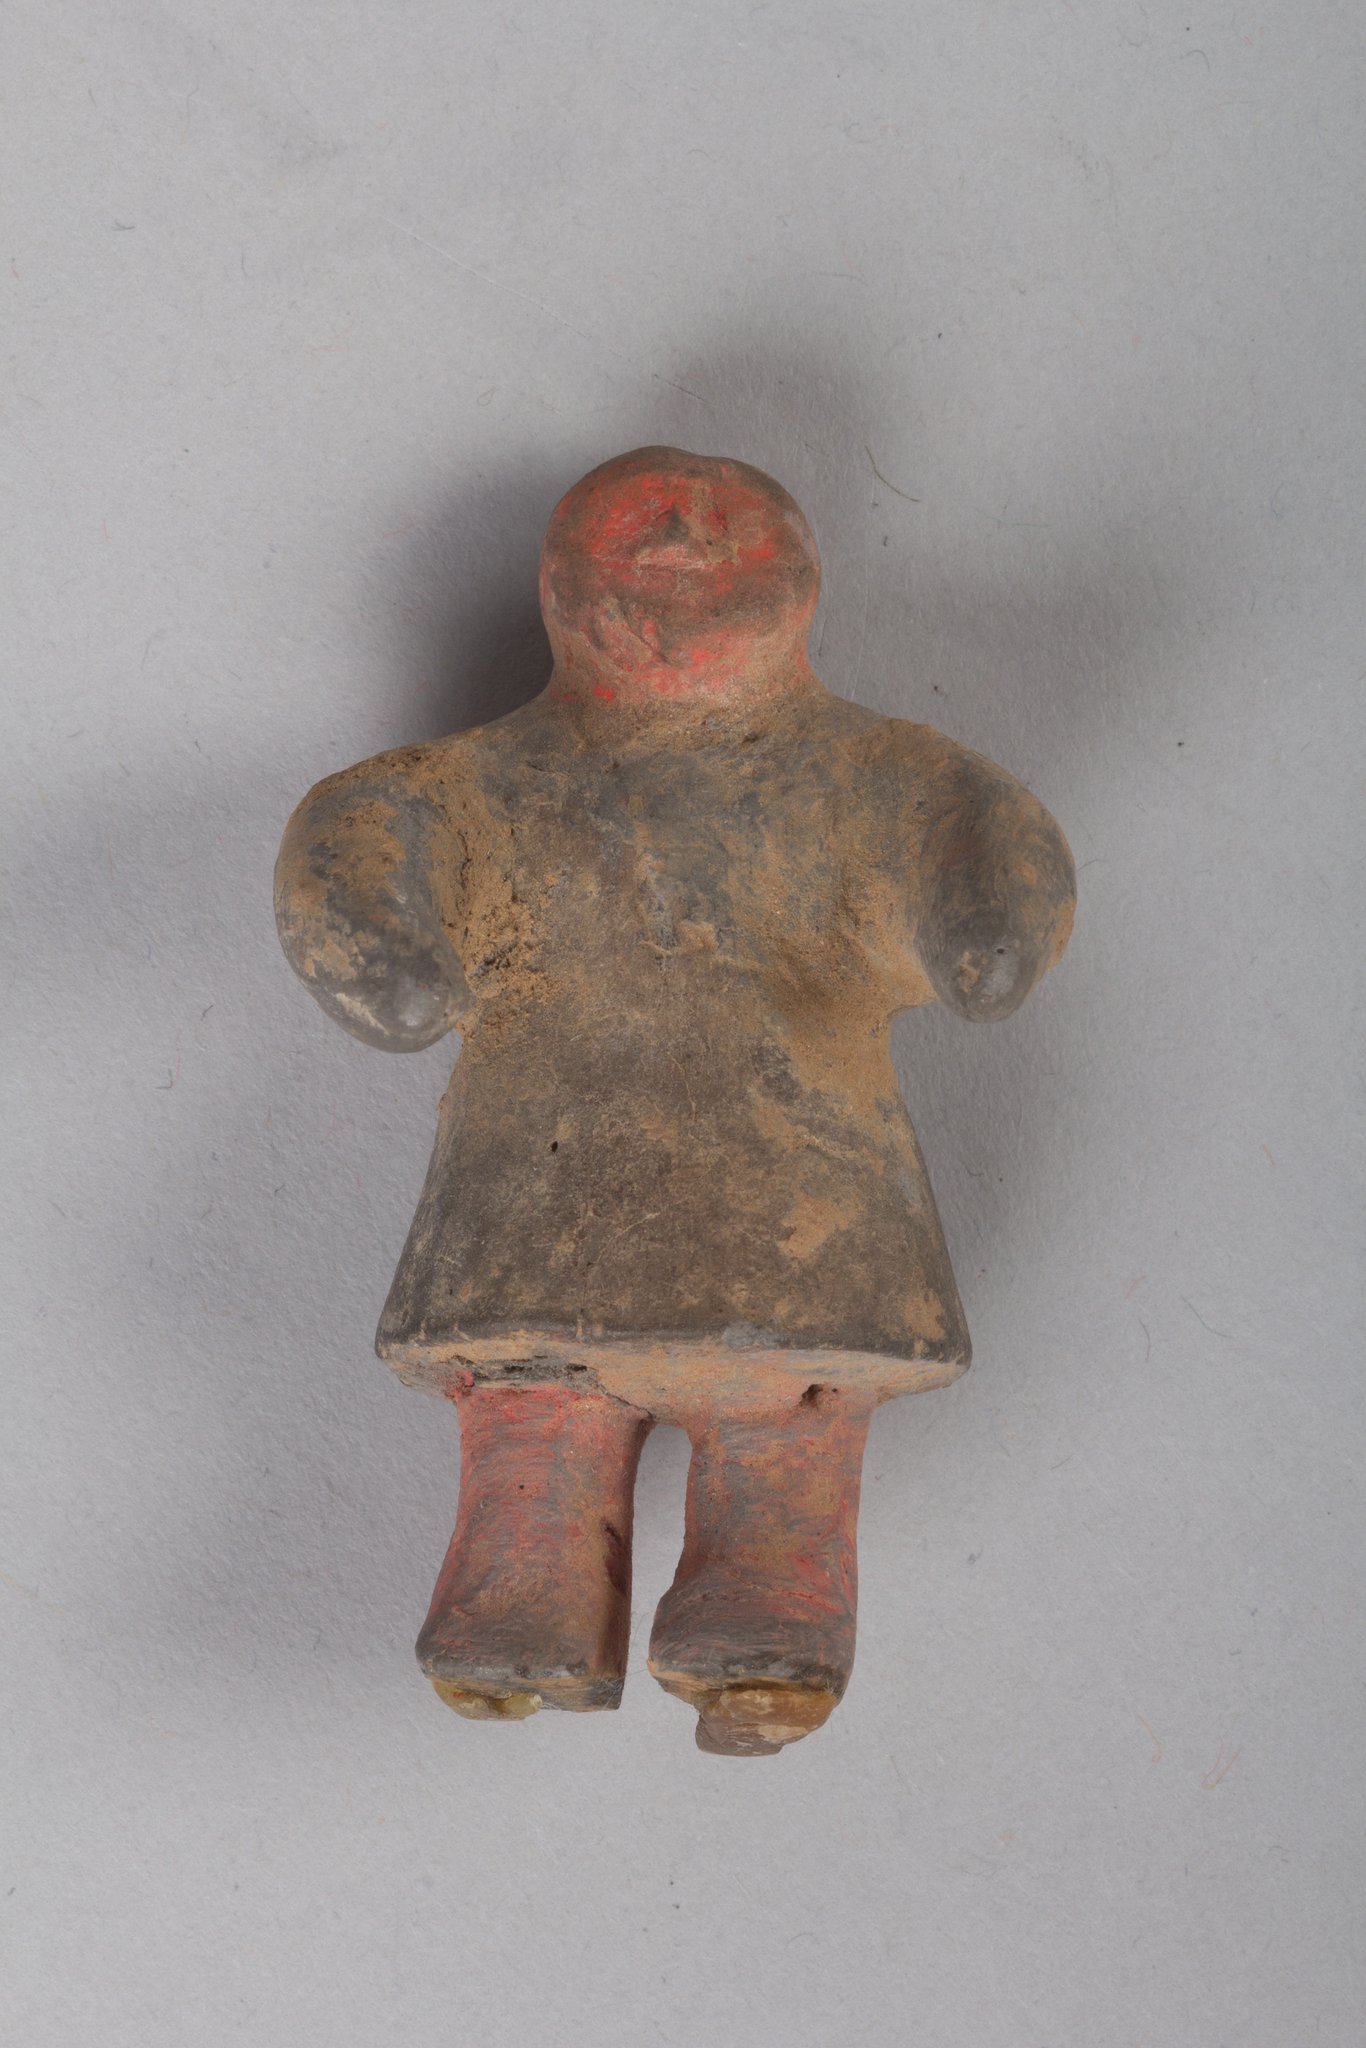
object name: figure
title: Figure of a child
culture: chinese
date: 770-256 BCE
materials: clay